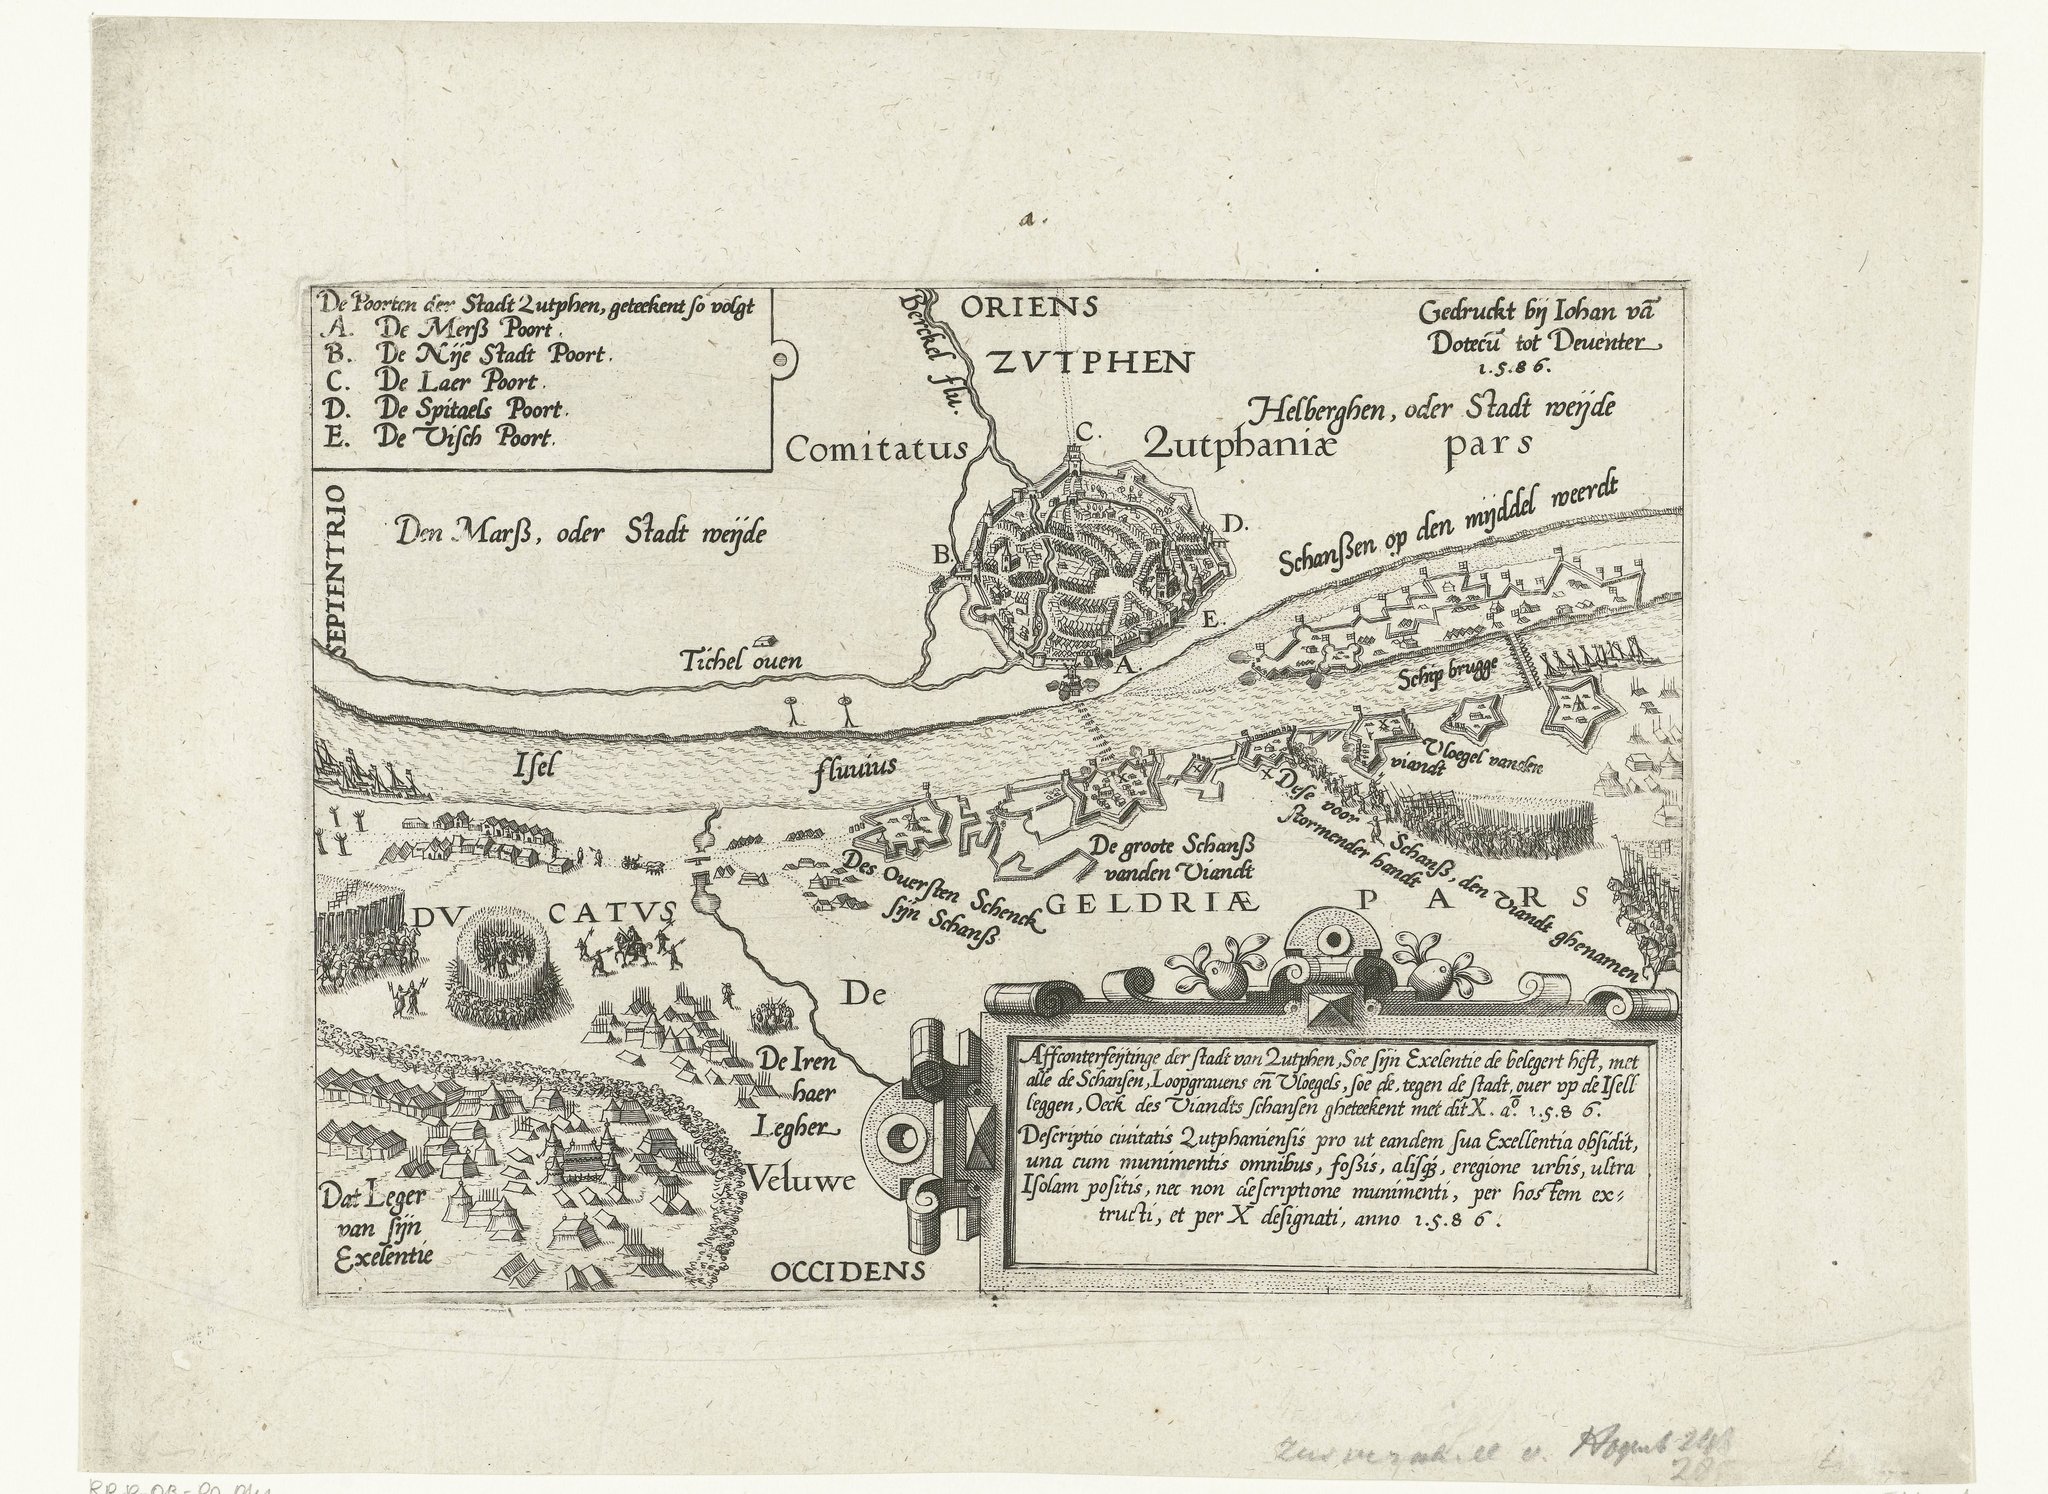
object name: print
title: Descriptio civitatis Zutphaniensis pro ut eandem sua Excellentia obsidit (...) anno 1.5.86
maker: joannes van doetechum (i)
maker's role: print maker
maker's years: 1528-1605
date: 1586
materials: paper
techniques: etching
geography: deventer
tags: robert dudley (1st earl of leicester), improvised bridge, temporary bridge ~ military engineering, siege, position war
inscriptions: date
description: Beleg van Zutphen door de troepen van de graaf van Leicester, september en oktober 1586. Gezicht op Zutphen en de Engelse en Spaanse schansen langs de IJssel, rechts de schipbrug. Rechtsonder een cartouche met de titels in het Nederlands en Latijn, linksboven een cartouche met de legenda A-E in het Nederlands.